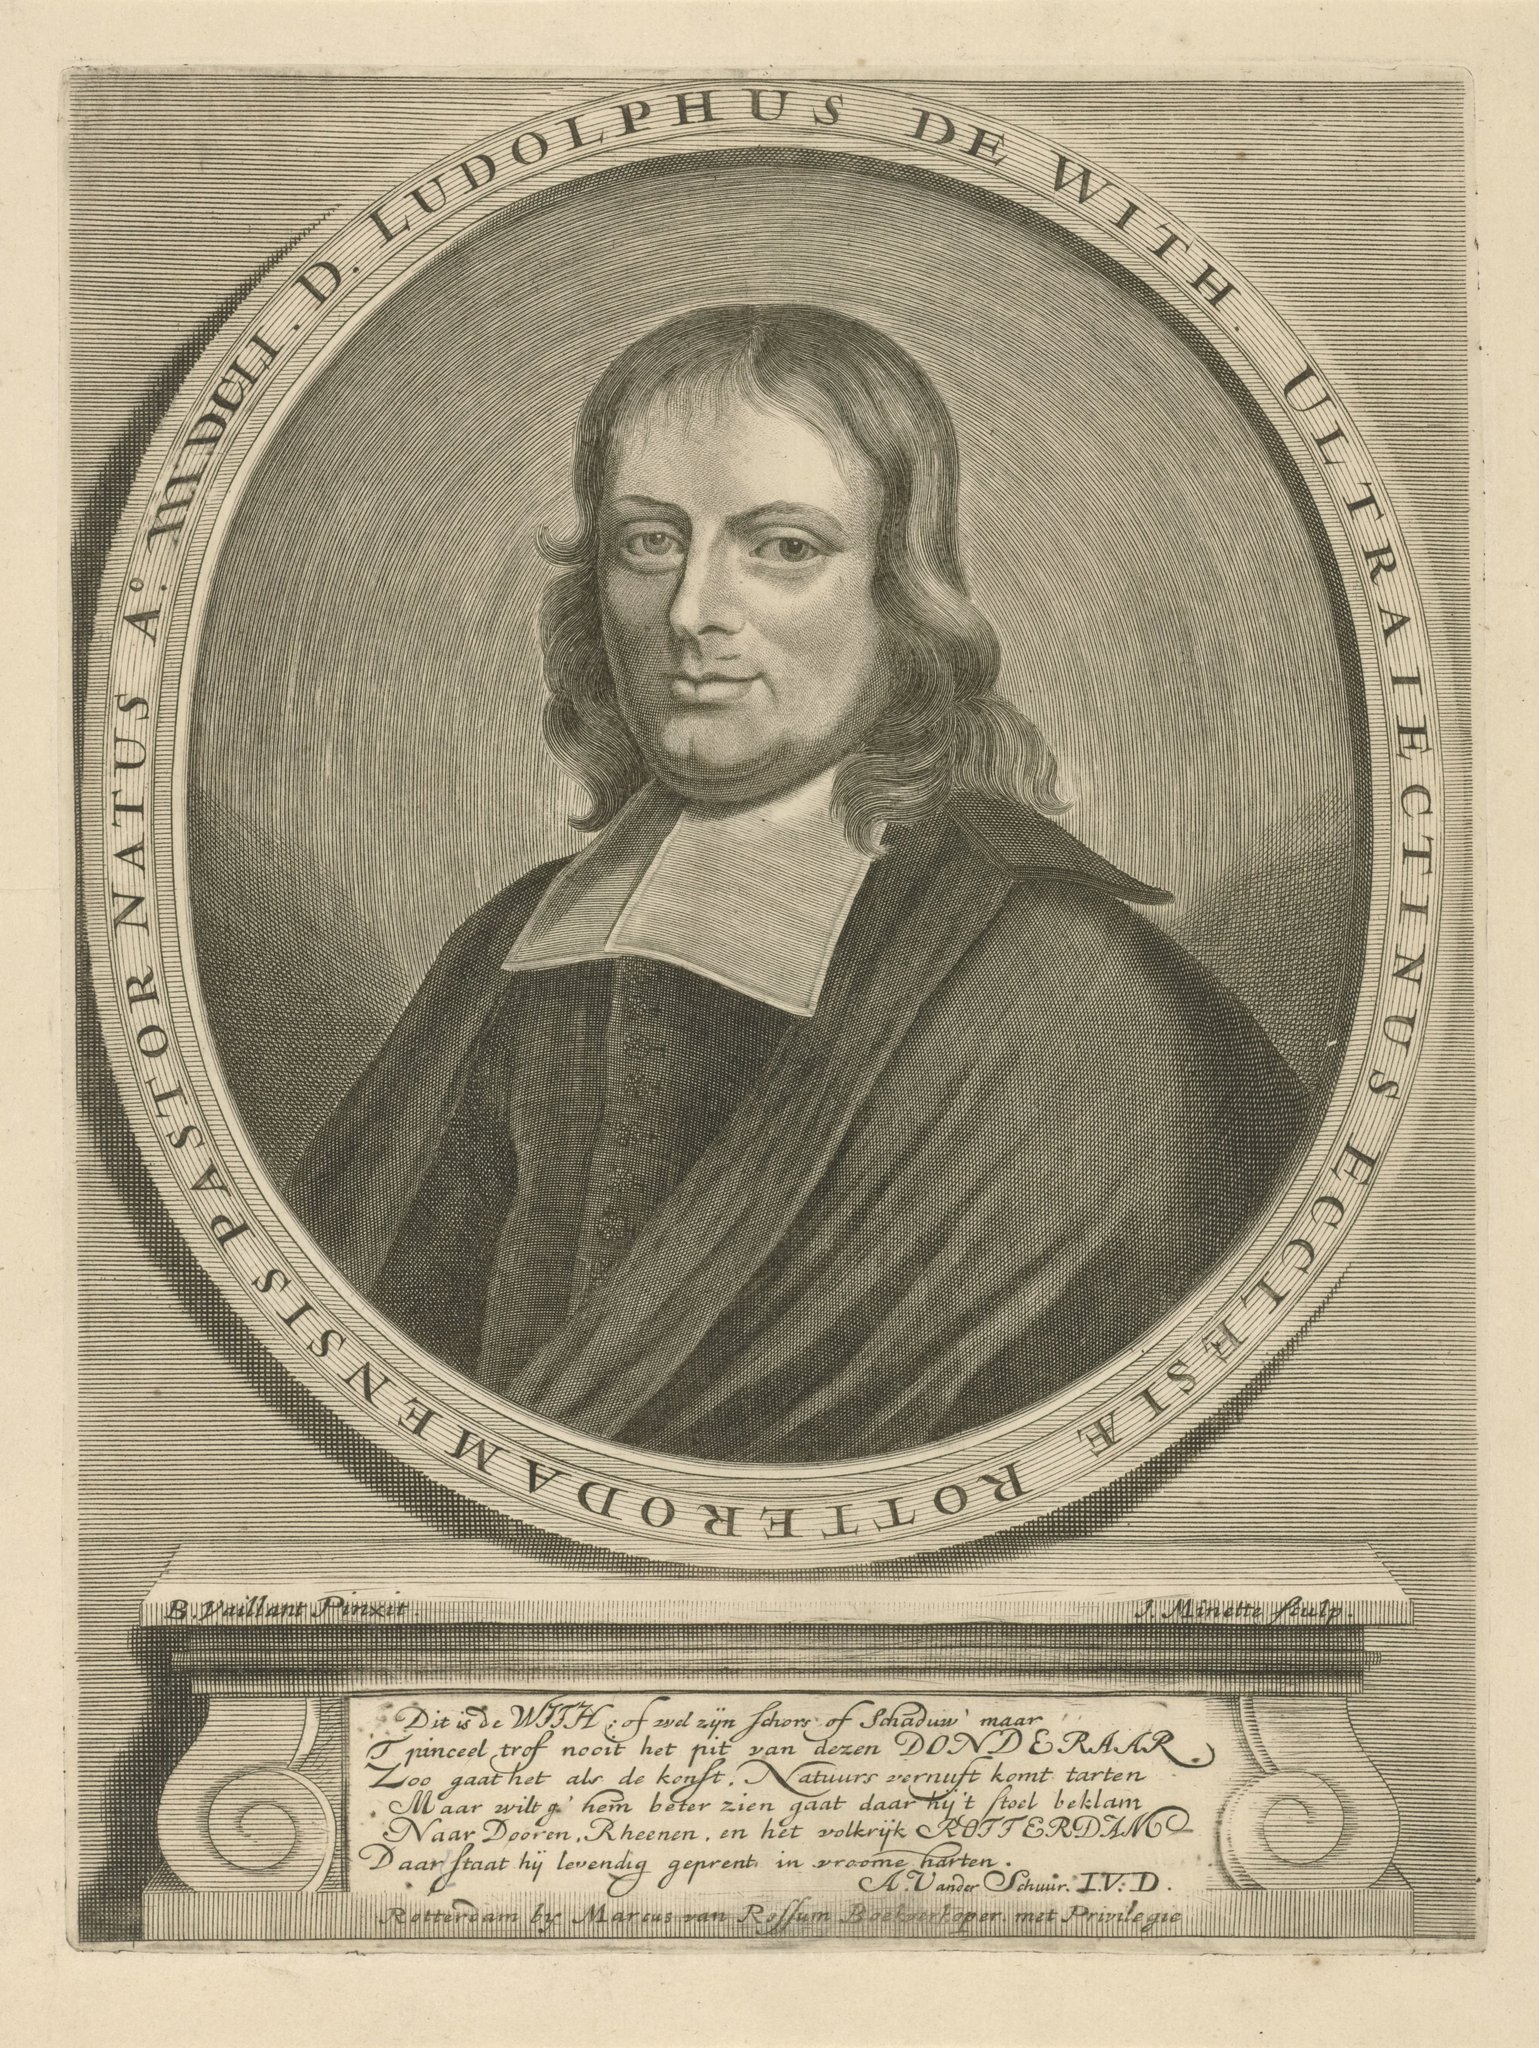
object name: print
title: Portret van Ludolfus de With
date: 1709-1726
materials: paper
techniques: engraving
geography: amsterdam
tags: utrecht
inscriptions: collector's mark: Lugt 2228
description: Portret van Ludolfus de With, predikant te Doorn, Rhenen en Rotterdam. Op het basement een vers in het Nederlands.